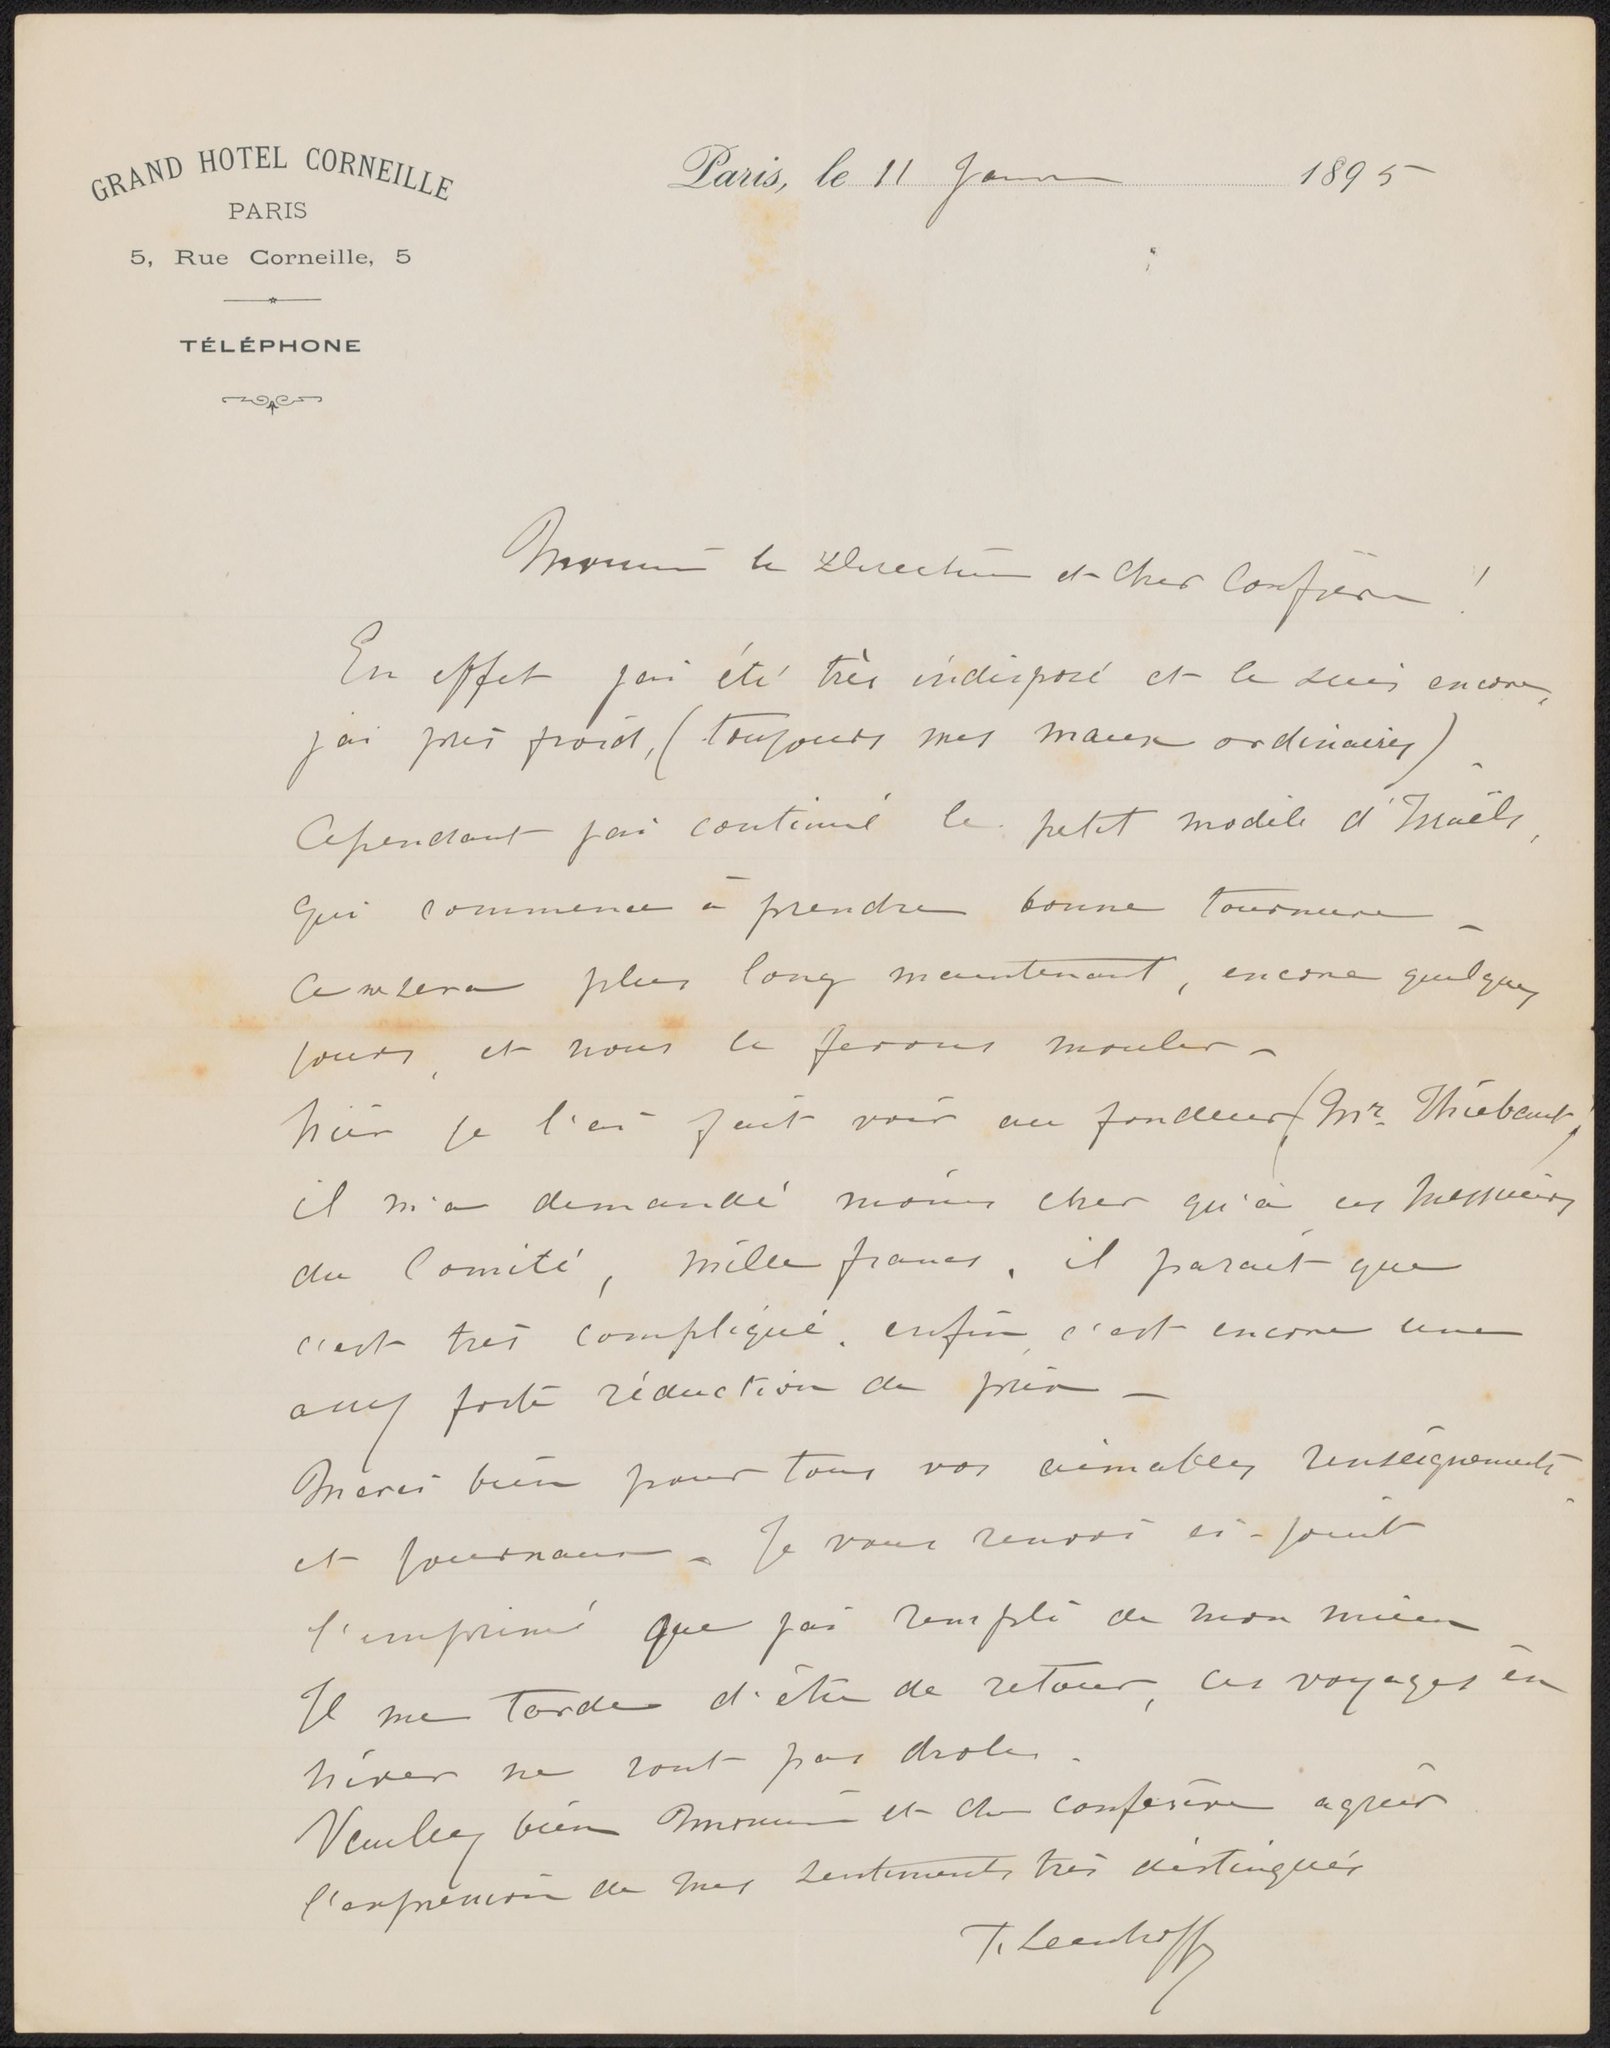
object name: letter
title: Brief aan August Allebé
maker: ferdinand leenhoff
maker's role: print maker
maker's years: 1841-1914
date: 1895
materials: ink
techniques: pen, printing, writing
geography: paris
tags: paris, caster, amsterdam, print maker, draughtsman, august allebé, the hague, painter, jozef israëls, art trade, art shop, sculpture